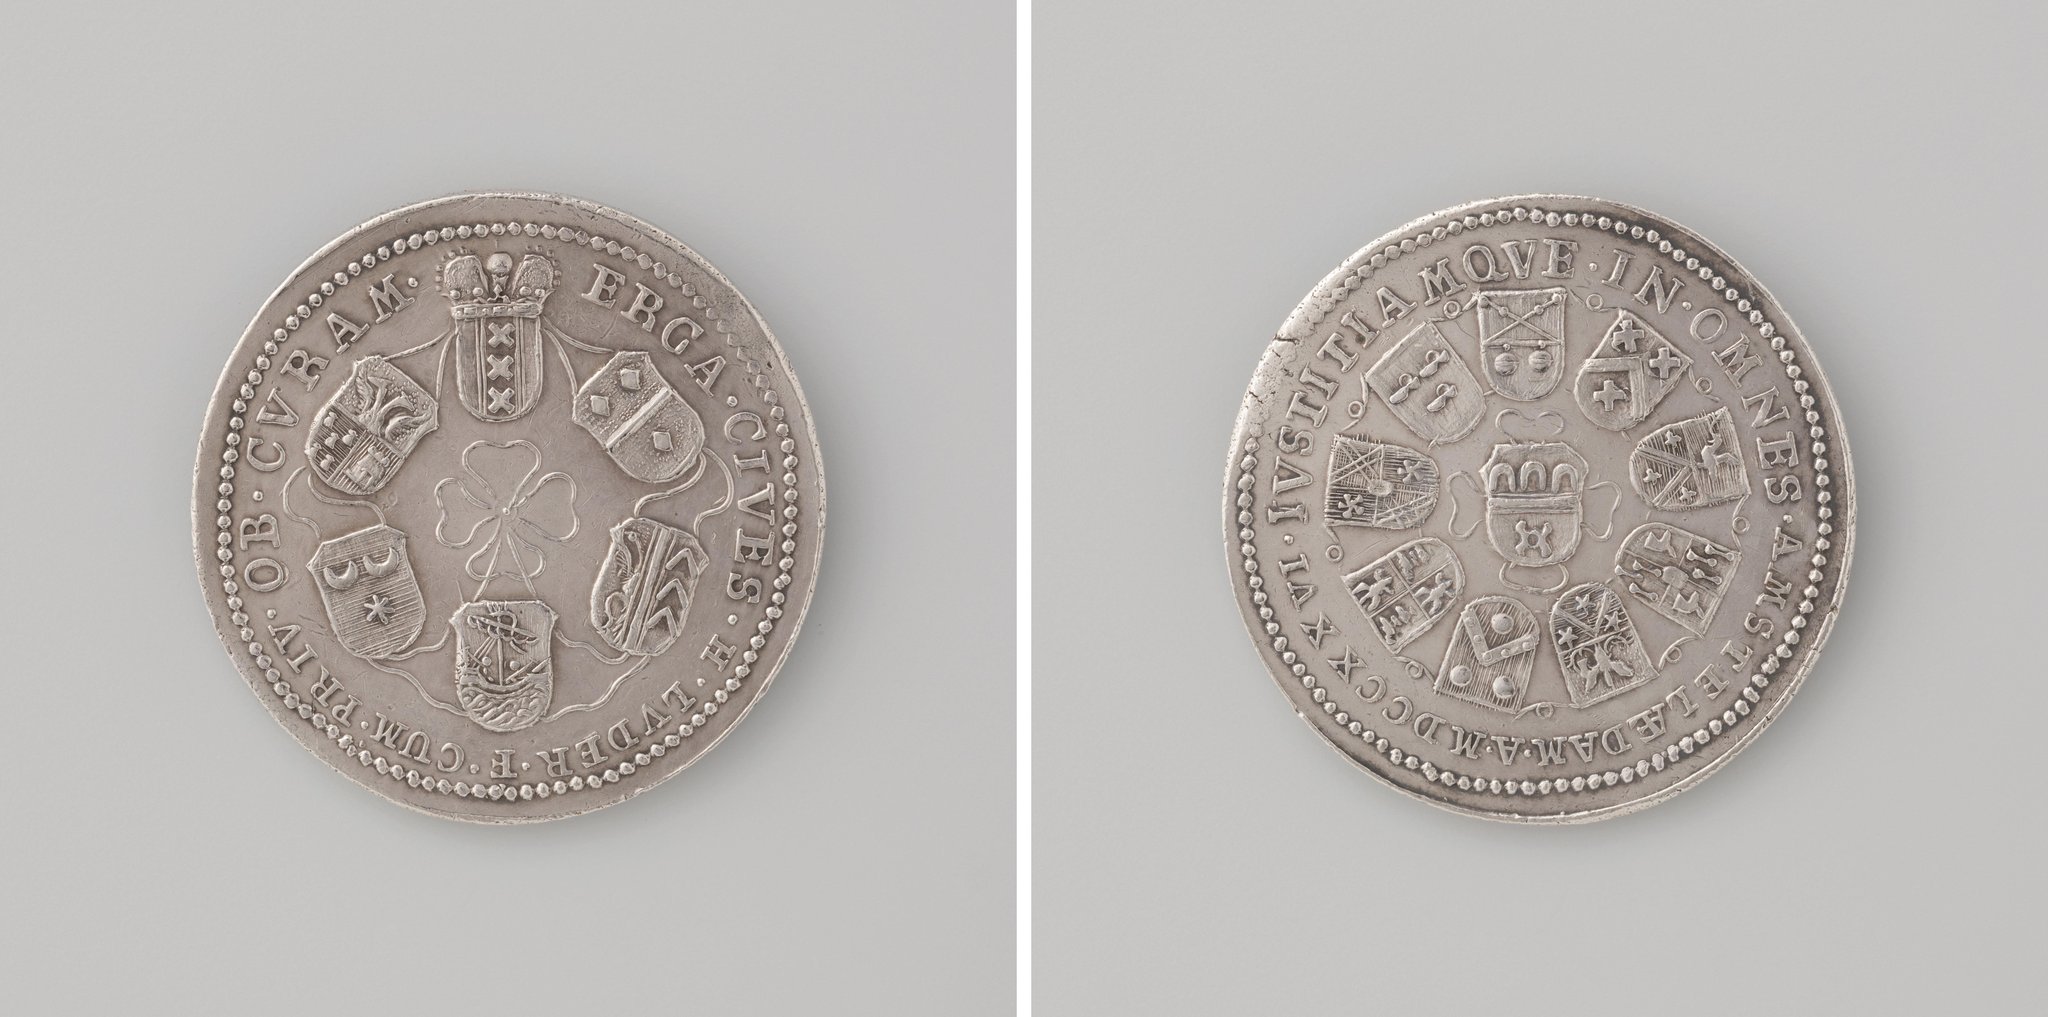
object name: lidmaatschapspenning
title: Amsterdam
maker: hans lueder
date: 1726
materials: silver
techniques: striking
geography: amsterdam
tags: amsterdam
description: Zilveren penning. Voorzijde: zes met linten aan elkaar verbonden wapenschilden: bovenste wapenschild met kroon van Amsterdam, onderste oude wapenschild van stad; daartussen wapenschilden van vier burgemeesters van 1726 binnen omschrift. Keerzijde: negen met linten aan elkaar verbonden wapenschilden met in midden tiende wapenschild: middelste wapenschild van hoofdofficier, wapenschilden eromheen van negen schepenen binnen omschrift.